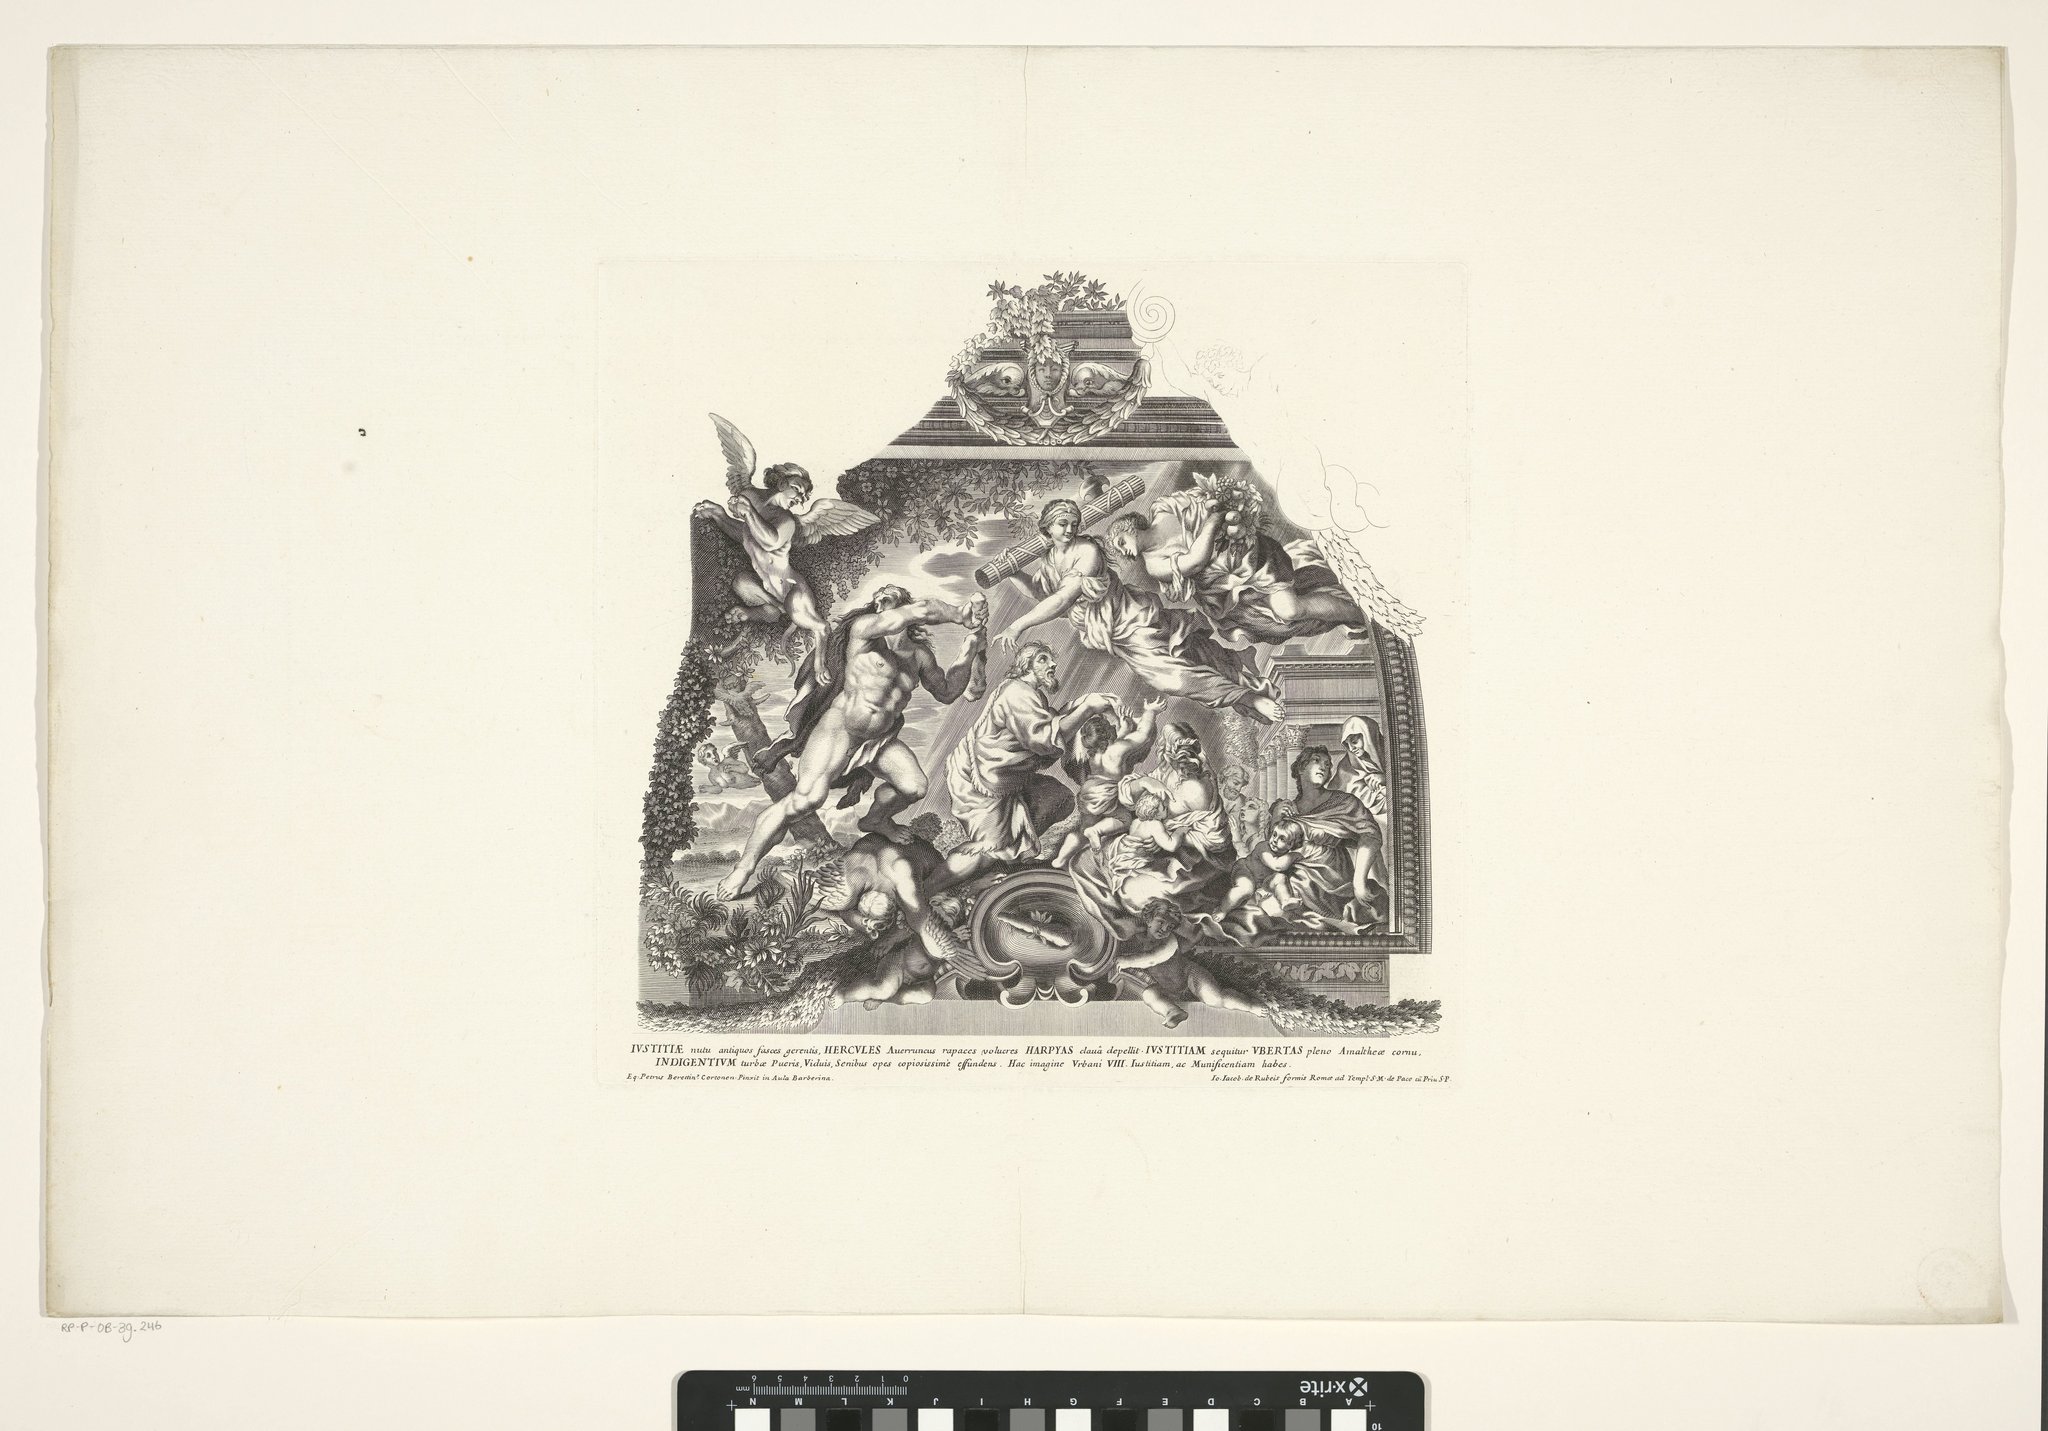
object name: print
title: Gewelfdecoratie uit Pallazzo Barberini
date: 1692-1762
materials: paper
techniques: engraving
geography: rome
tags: (story of) hercules (heracles), justitia (justice) as roman personification, harpy (fabulous bird); 'arpie' (ripa), abundantia (abundance) as roman personification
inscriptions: collector's mark: Lugt 240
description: Deel van de gewelfdecoratie in de salon van Palazzo Barberini met Hercules die de Harpijen verjaagt, zodat Rechtvaardigheid en Overvloed de armen kunnen helpen. Tekst in het Latijn in ondermarge.